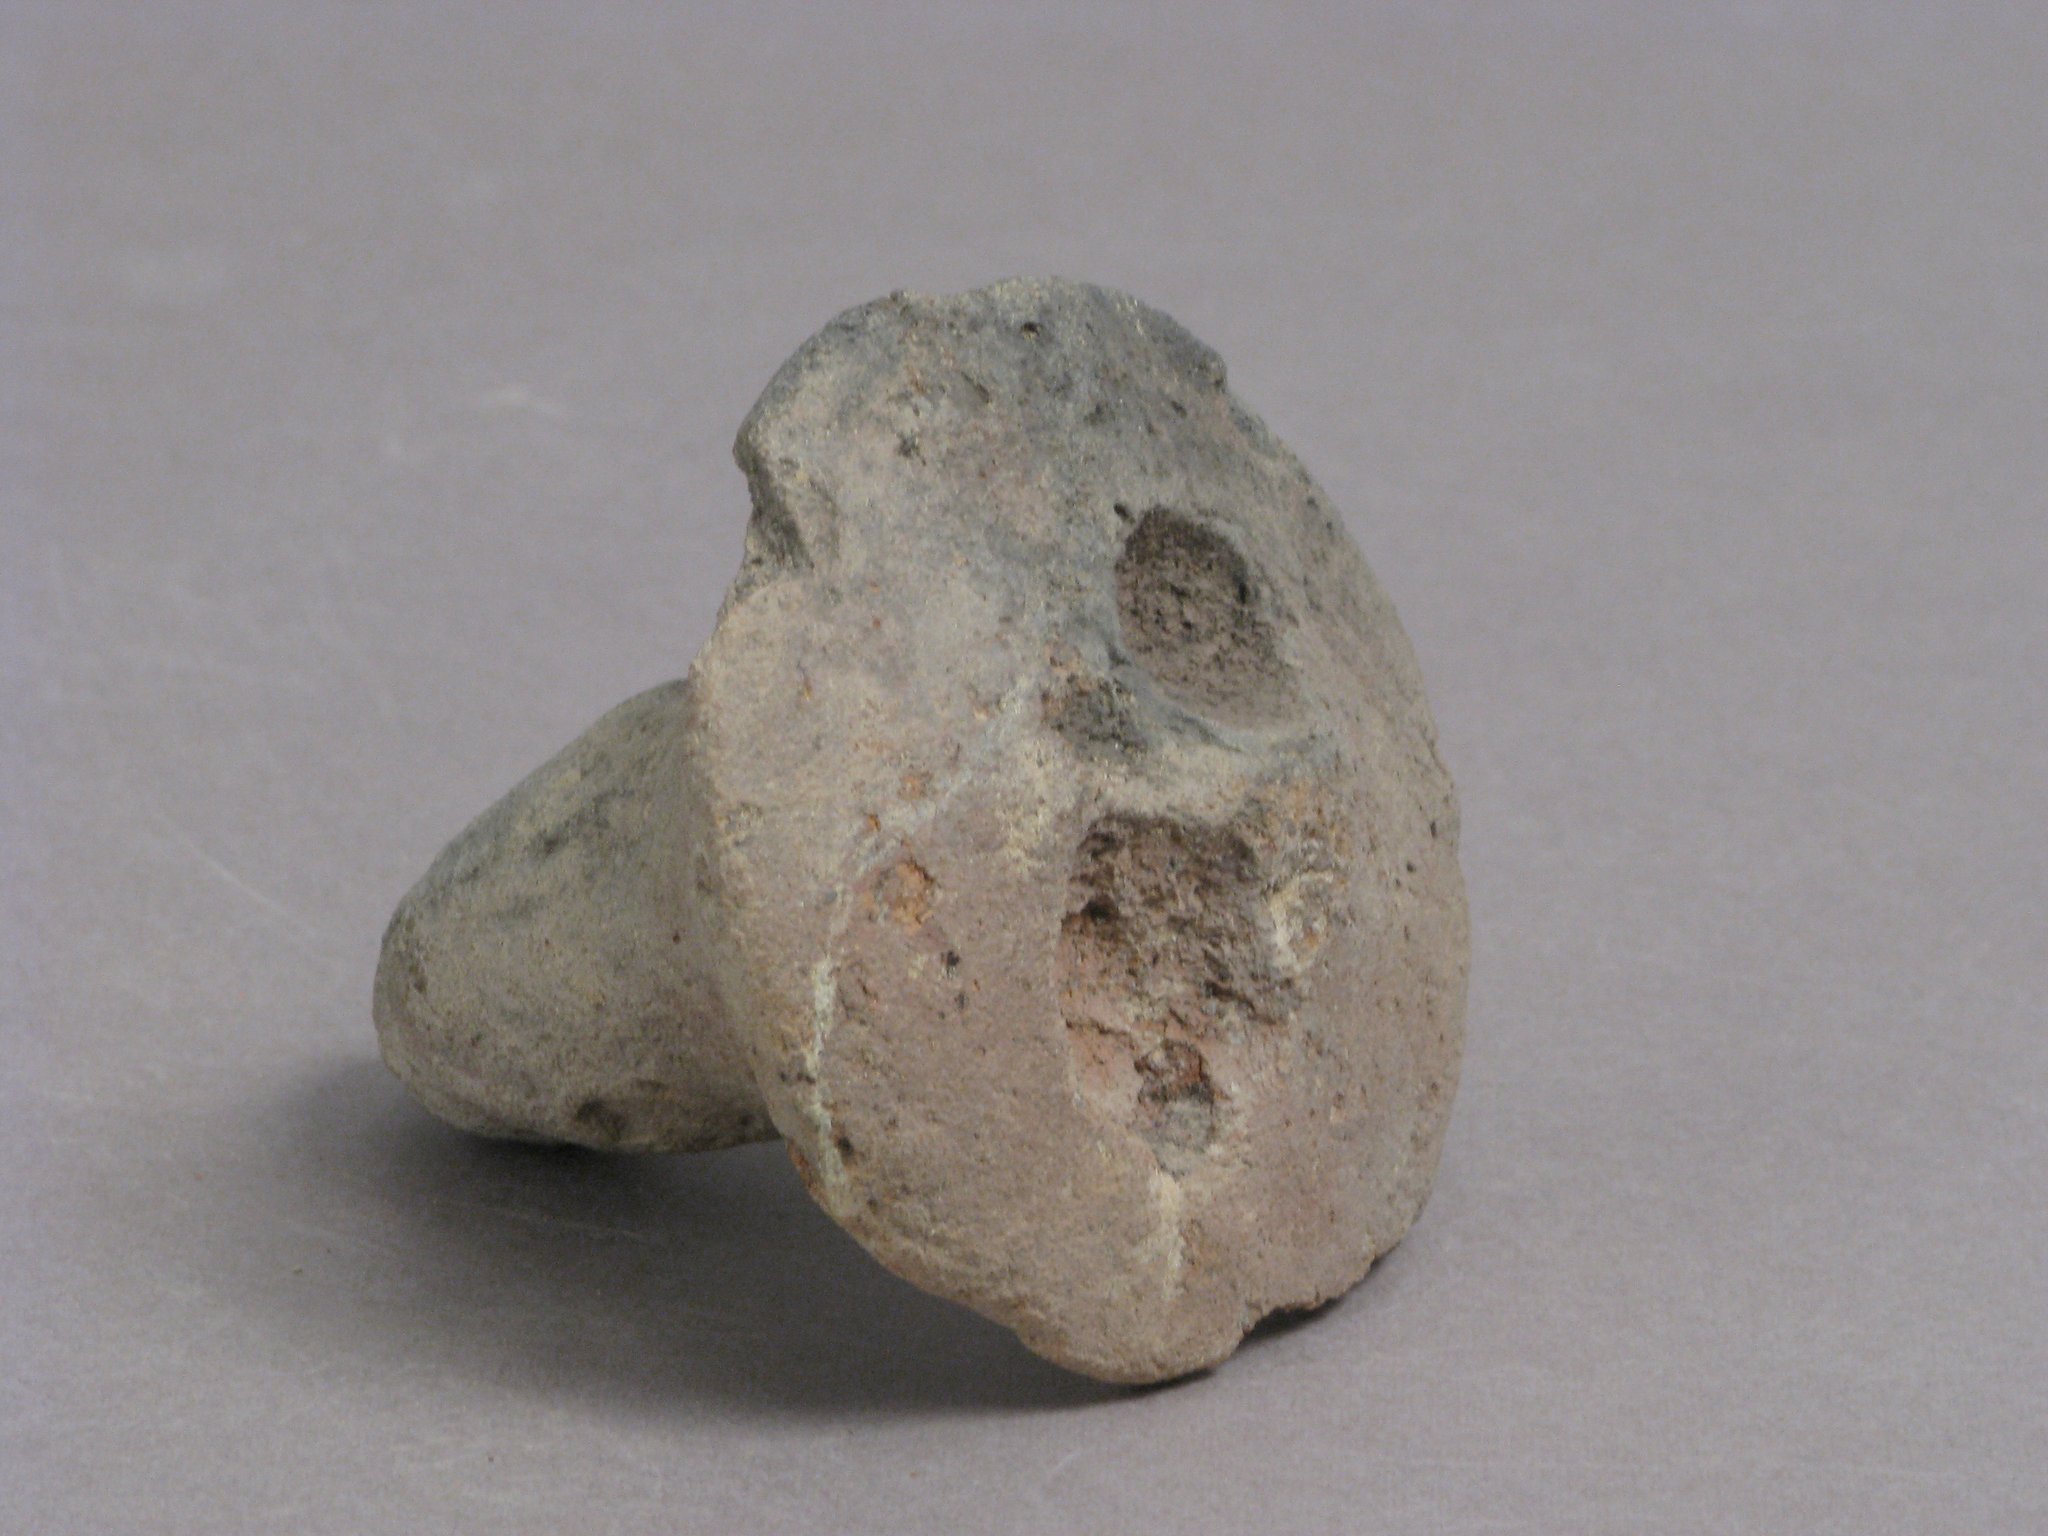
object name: lid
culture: coptic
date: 301-700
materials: earthenware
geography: egypt